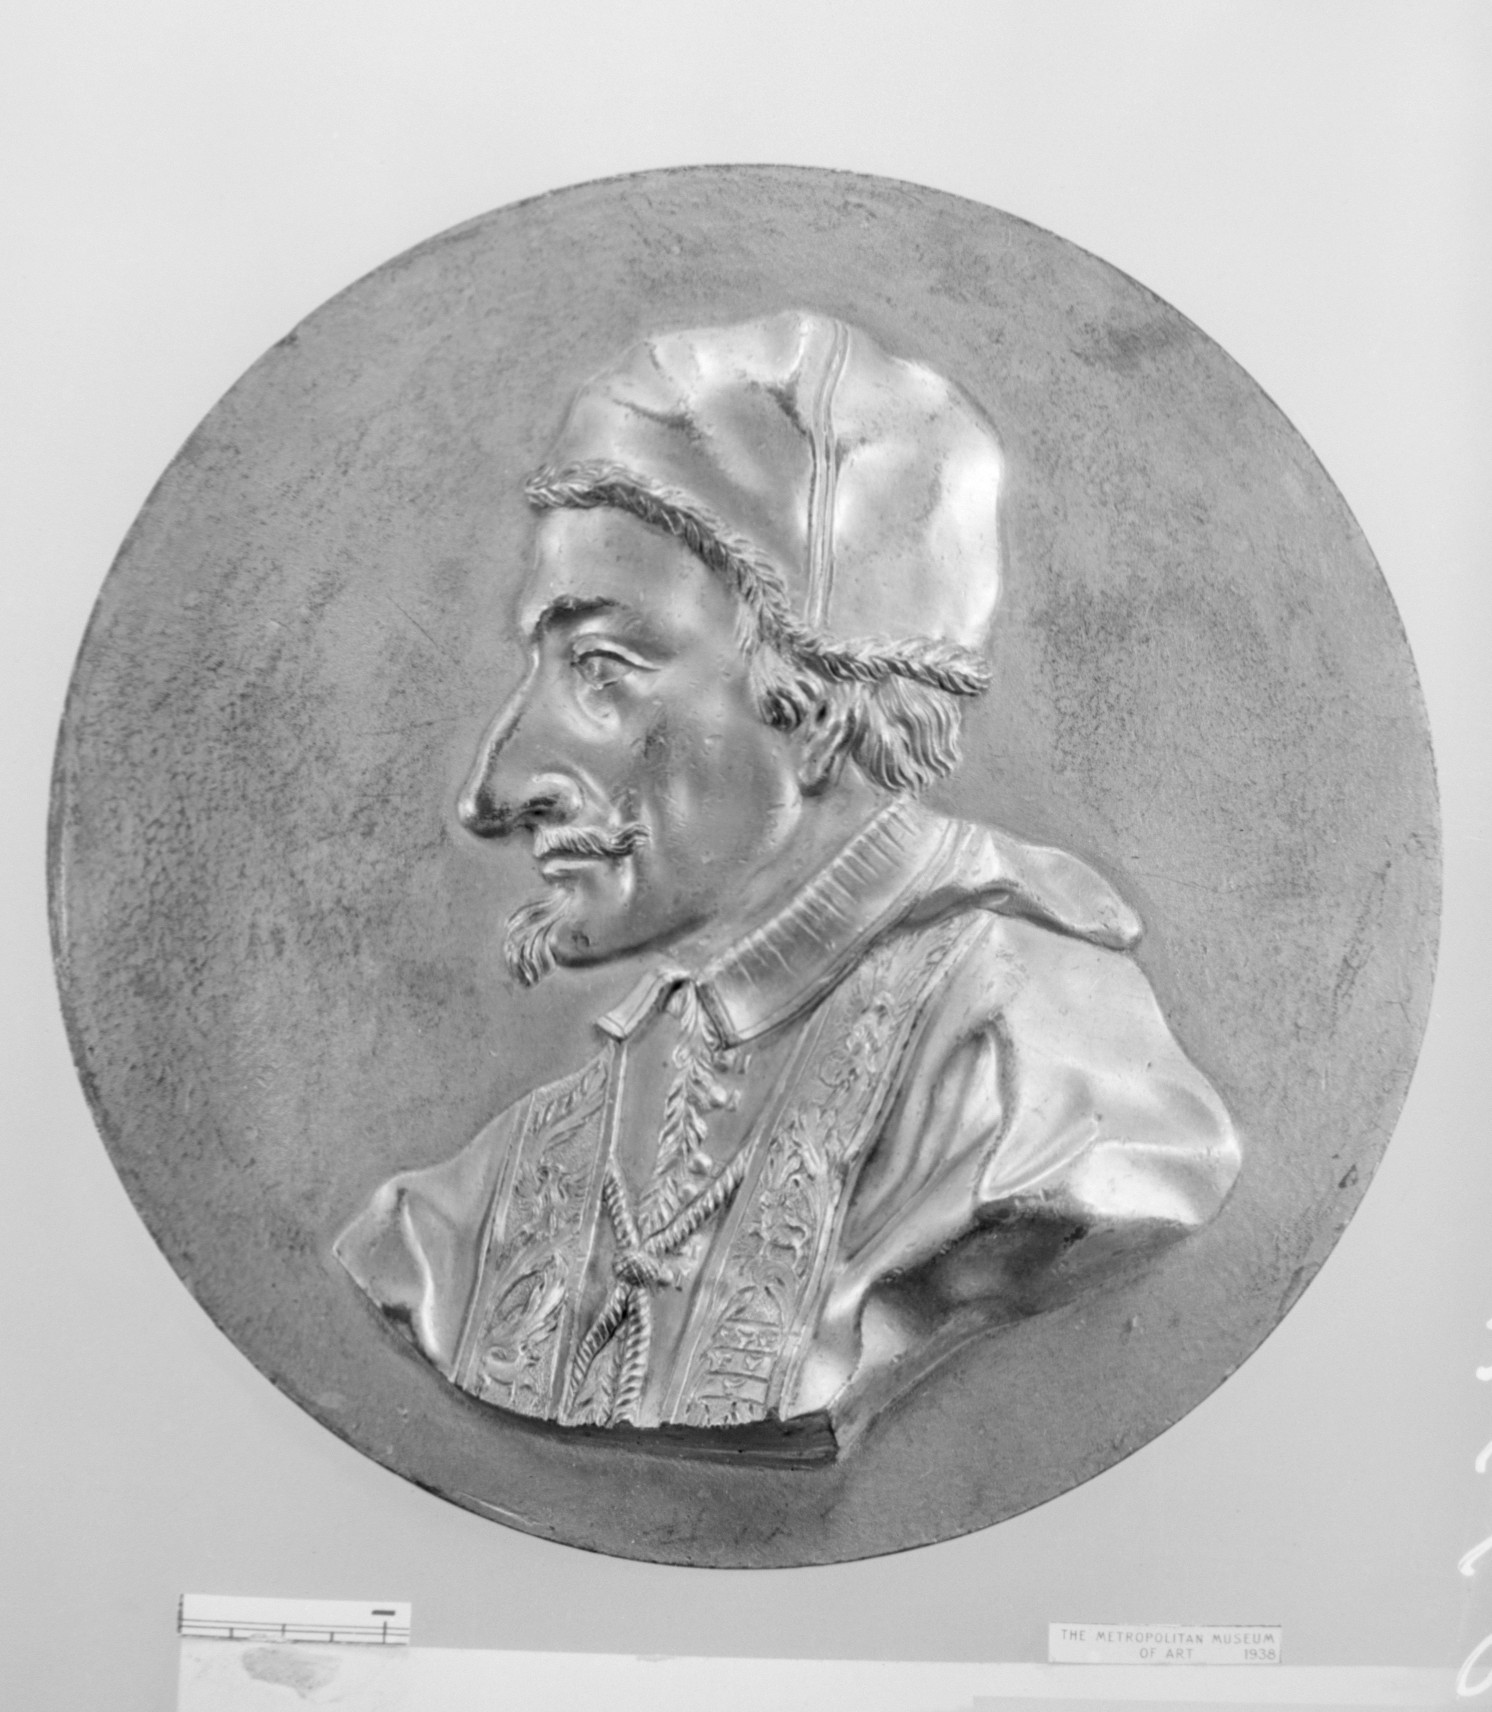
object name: medallion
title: Pope Innocent XI (Benedetto Odescalchi) (1611–1689, Pope 1676–89)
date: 1676-1678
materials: gilt bronze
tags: profiles,popes